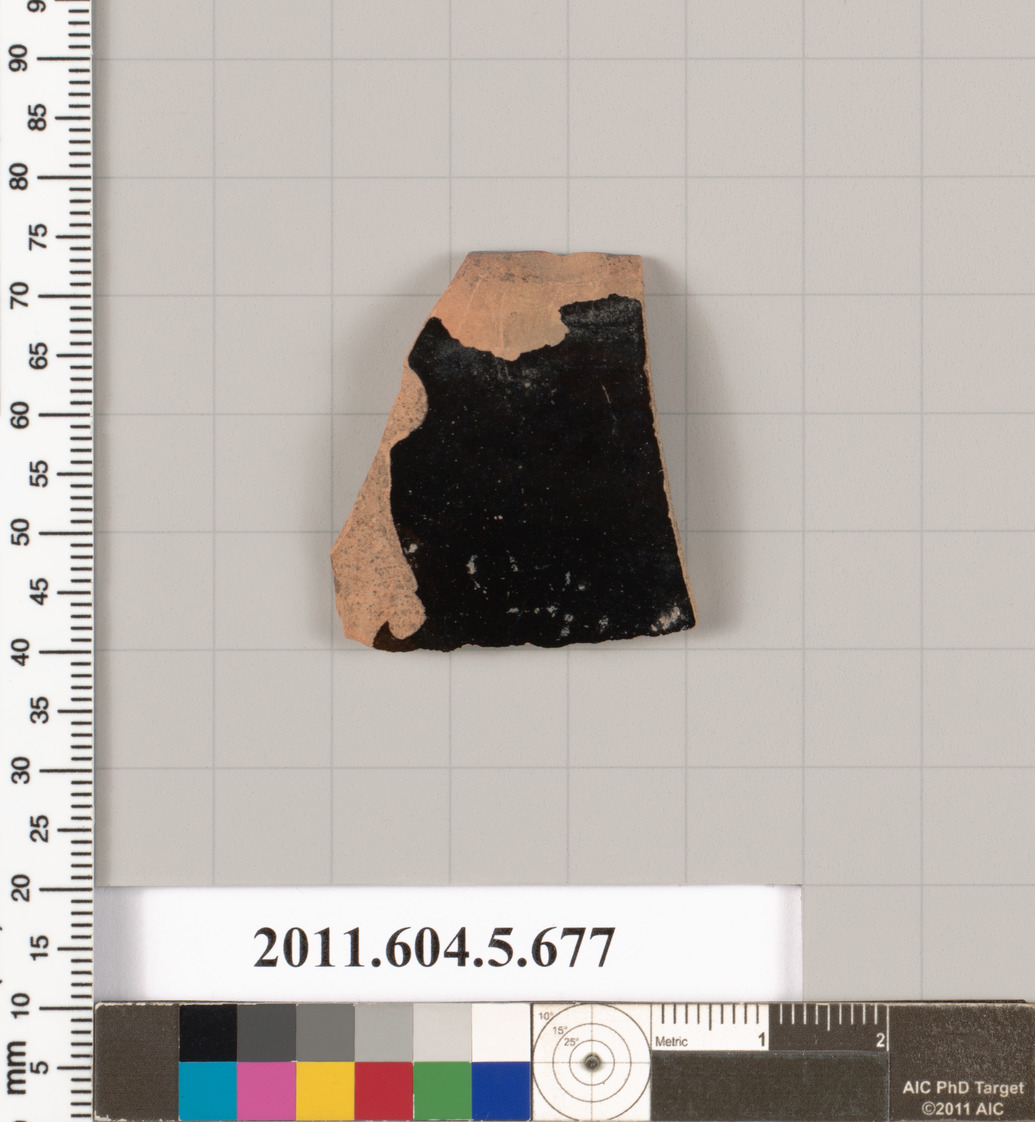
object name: kylix fragment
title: Terracotta rim fragment of a kylix (drinking cup)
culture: greek, attic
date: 600-401 BCE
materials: terracotta